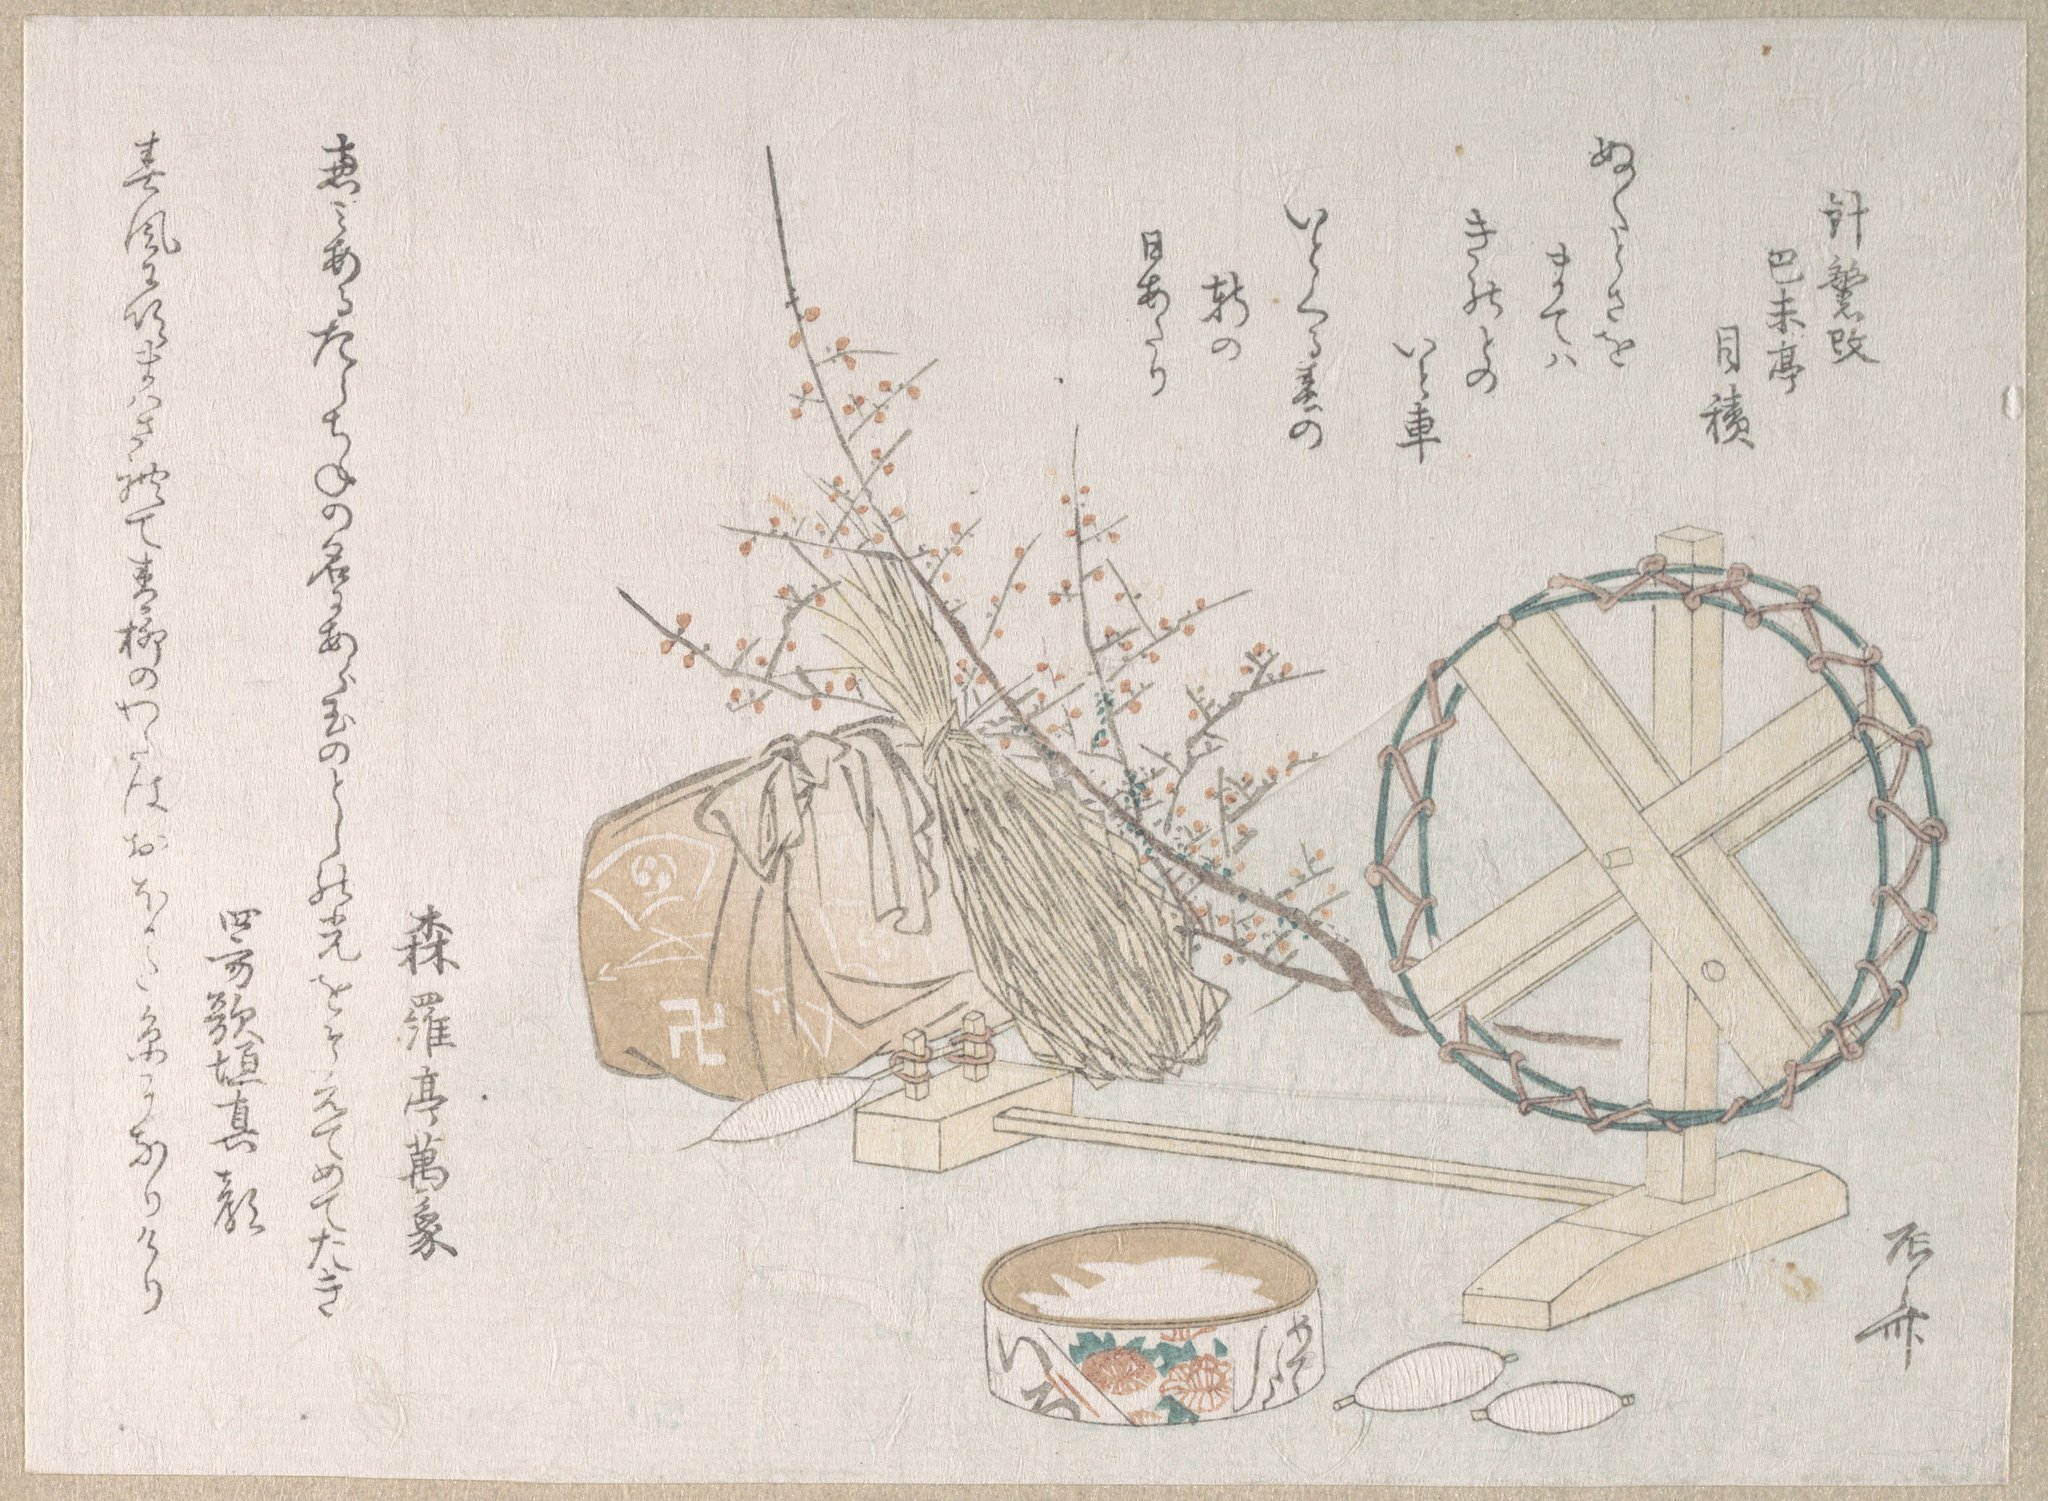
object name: print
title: Spinning Wheel and Spools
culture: japanese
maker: ryūryūkyo shinsai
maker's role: artist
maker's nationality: japanese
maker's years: 1799-1823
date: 1801-1900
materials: ink, paper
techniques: surimono, woodblock print